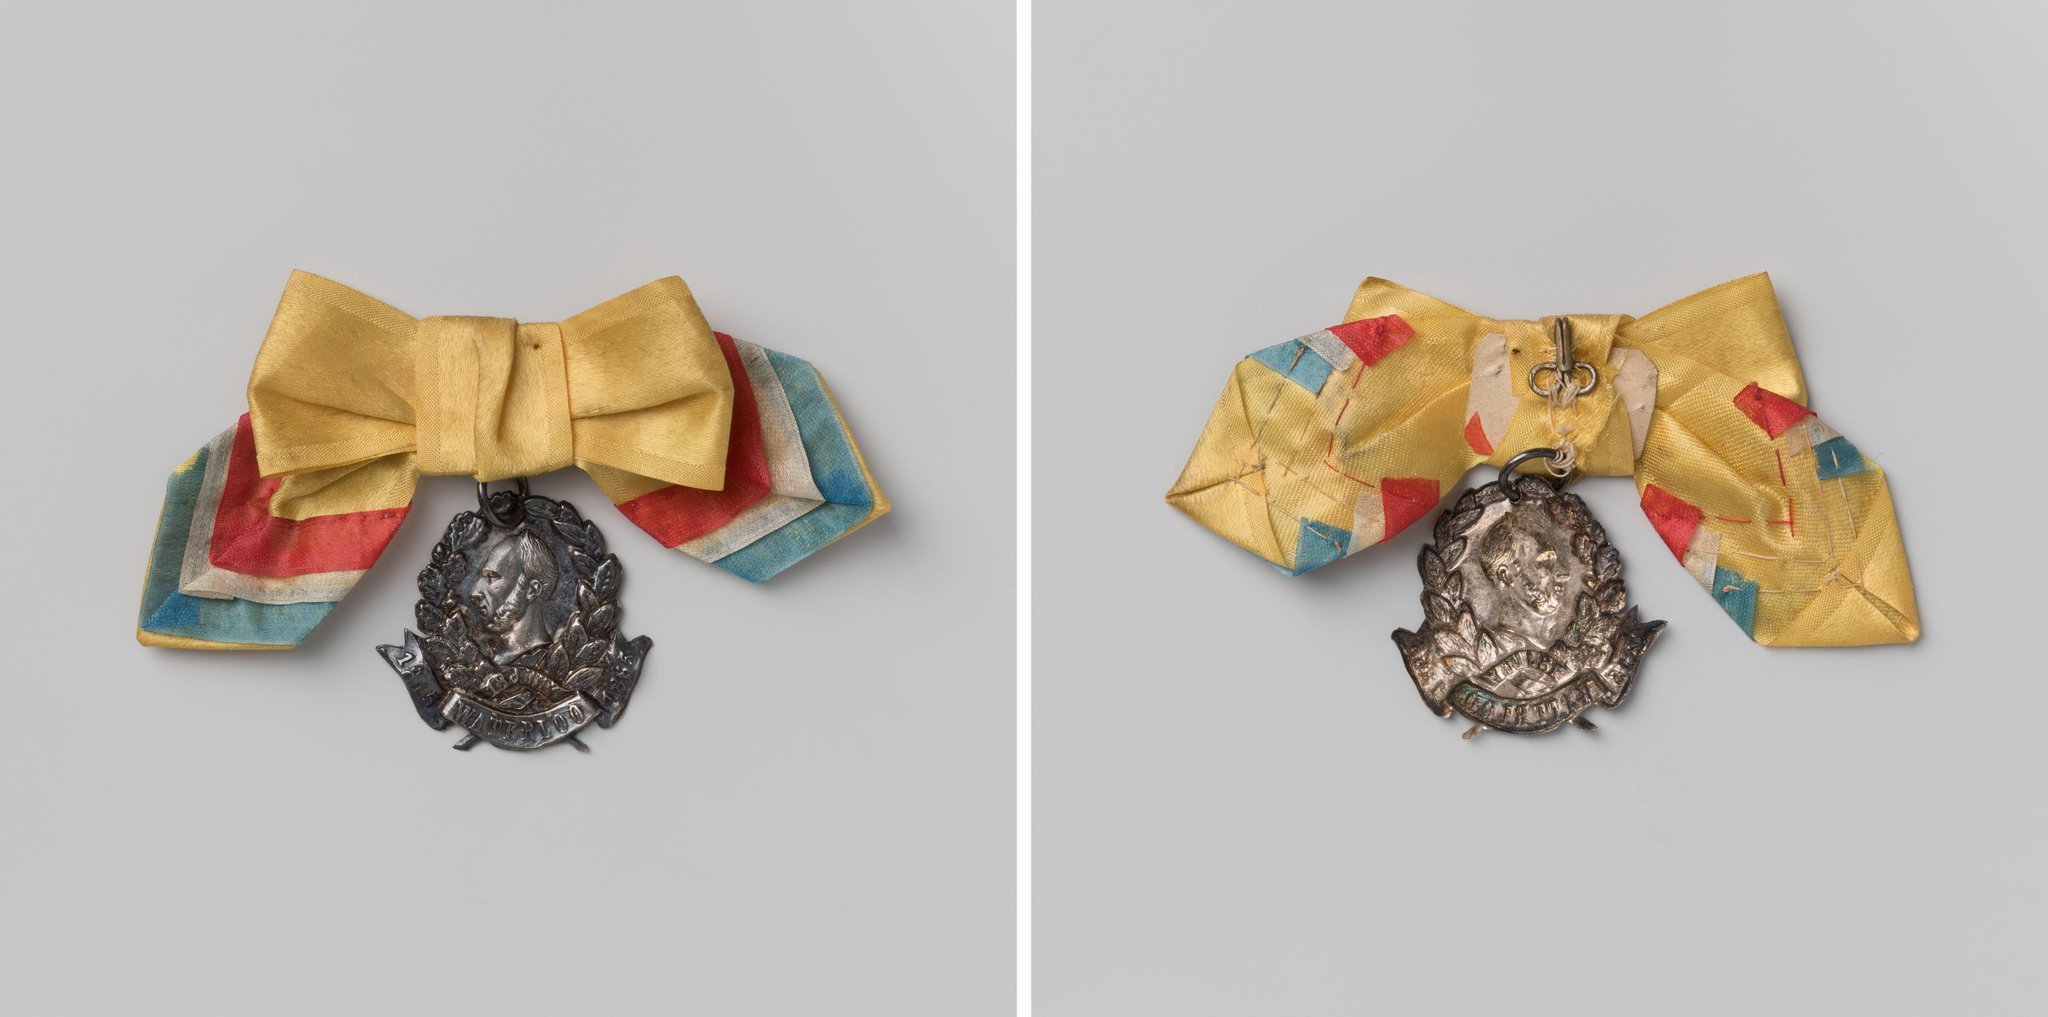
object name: insignia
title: Vijftigjarige herdenking van de slag bij Waterloo, ter ere van Willem II, koning der Nederlanden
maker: Anonymous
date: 1815-1865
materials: silver, textile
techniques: striking, weave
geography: netherlands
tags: the hague, william ii of the netherlands, waterloo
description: Eenzijdig zilveren draagteken binnen eikekrans, boven wimpel aan draagring en lint, bestaande uit gele strik en rood-wit-blauw-geel gestreept lint. Voorzijde: borststuk man boven opschrift; op wimpel: opschrift